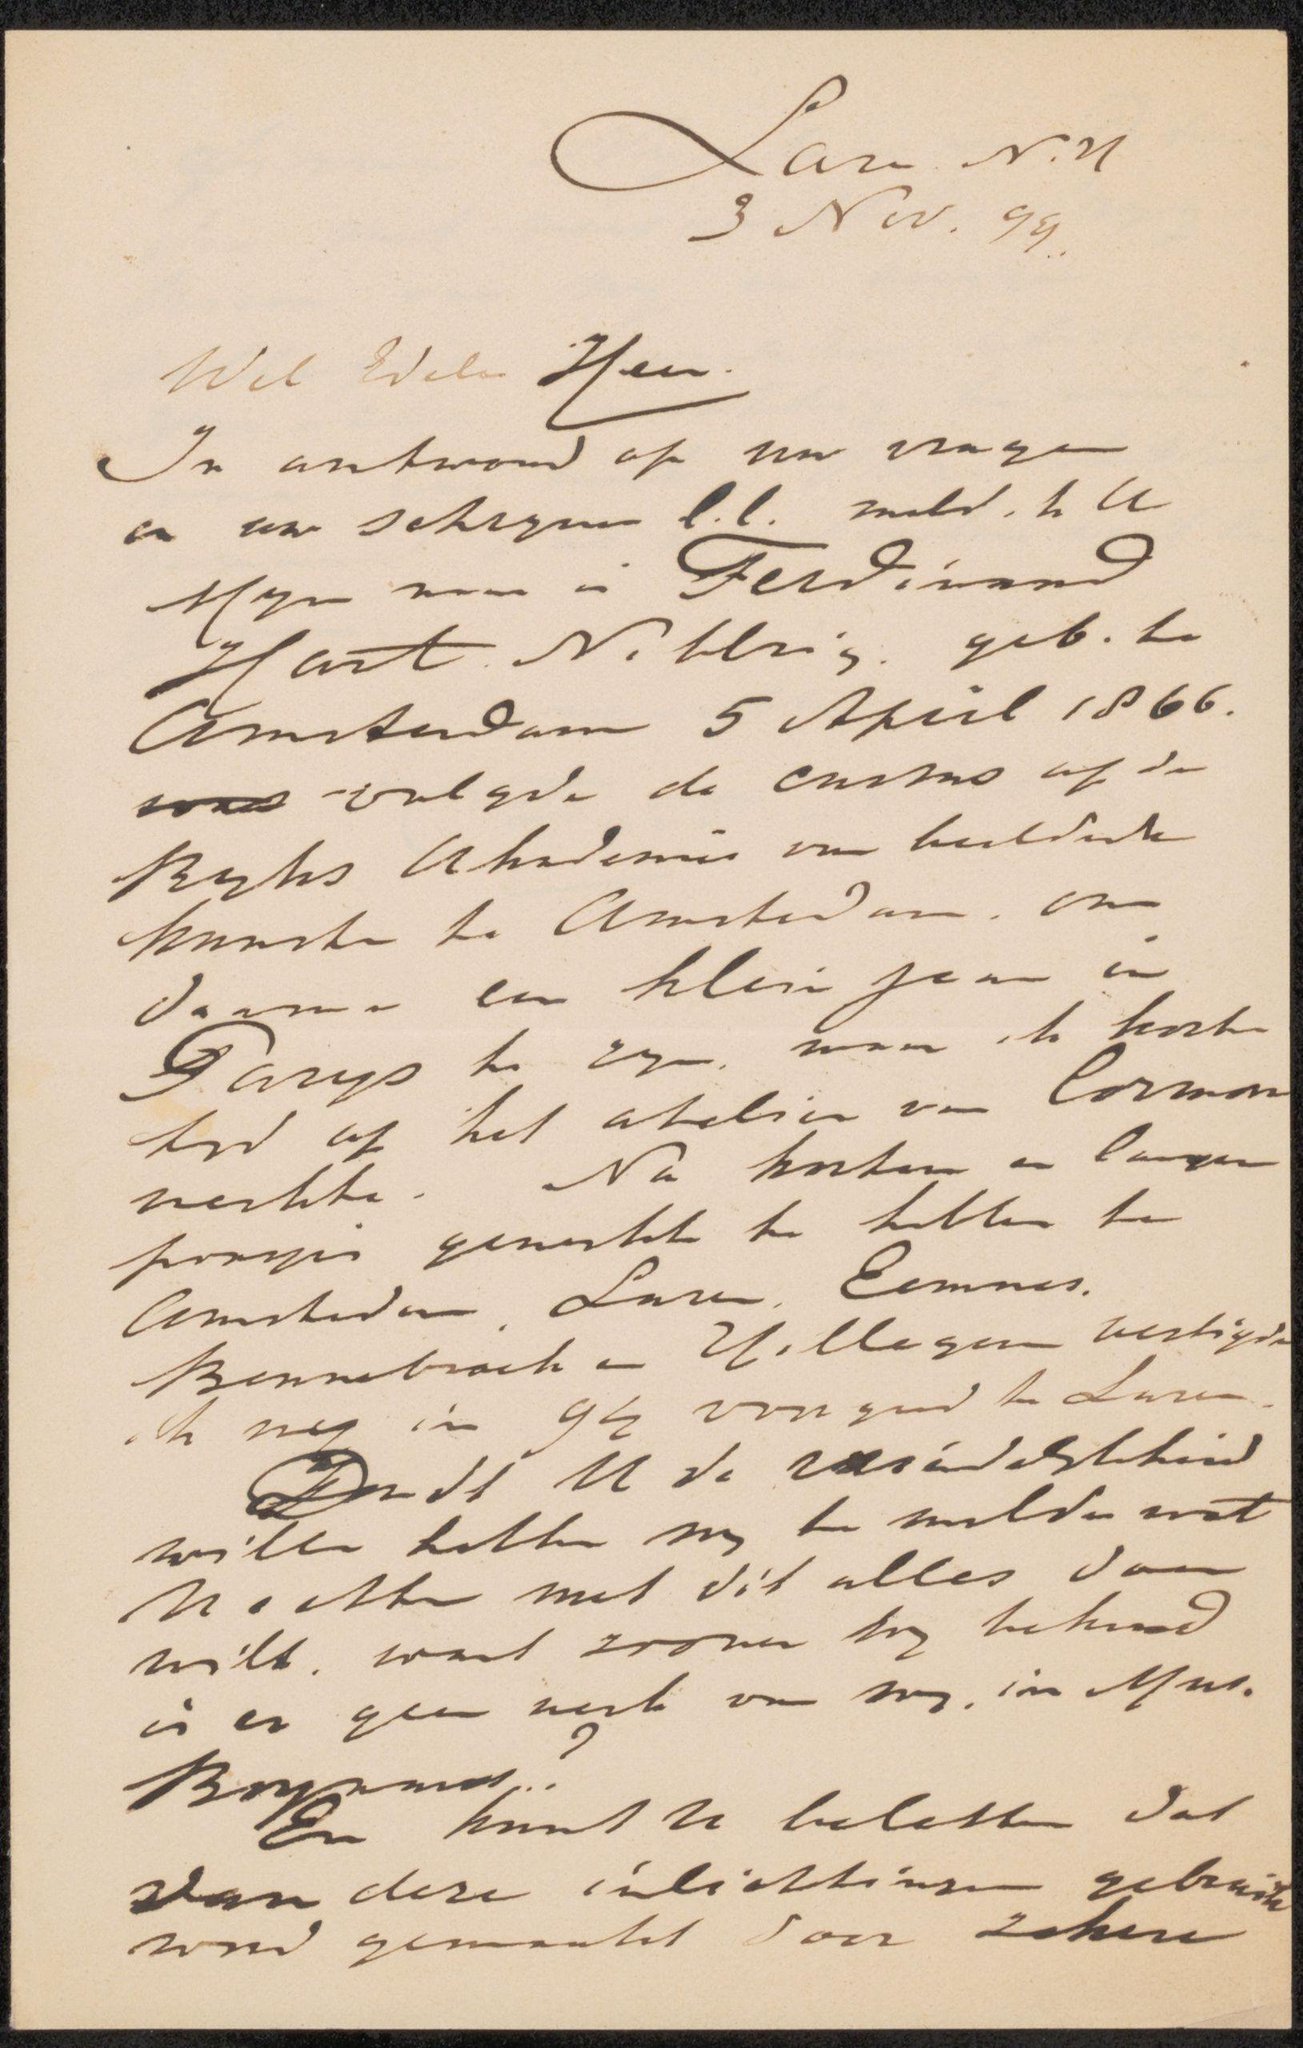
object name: letter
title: Brief aan Pieter Haverkorn van Rijsewijk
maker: ferdinand hart nibbrig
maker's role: draughtsman, painter, print maker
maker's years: 1866-1915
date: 1899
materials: ink, paper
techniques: pen, writing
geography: laren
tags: painter, fernand piestre cormon, pieter haverkorn van rijsewijk, education, tuition of the artist (in general), workshop, studio of the artist (in general), paris